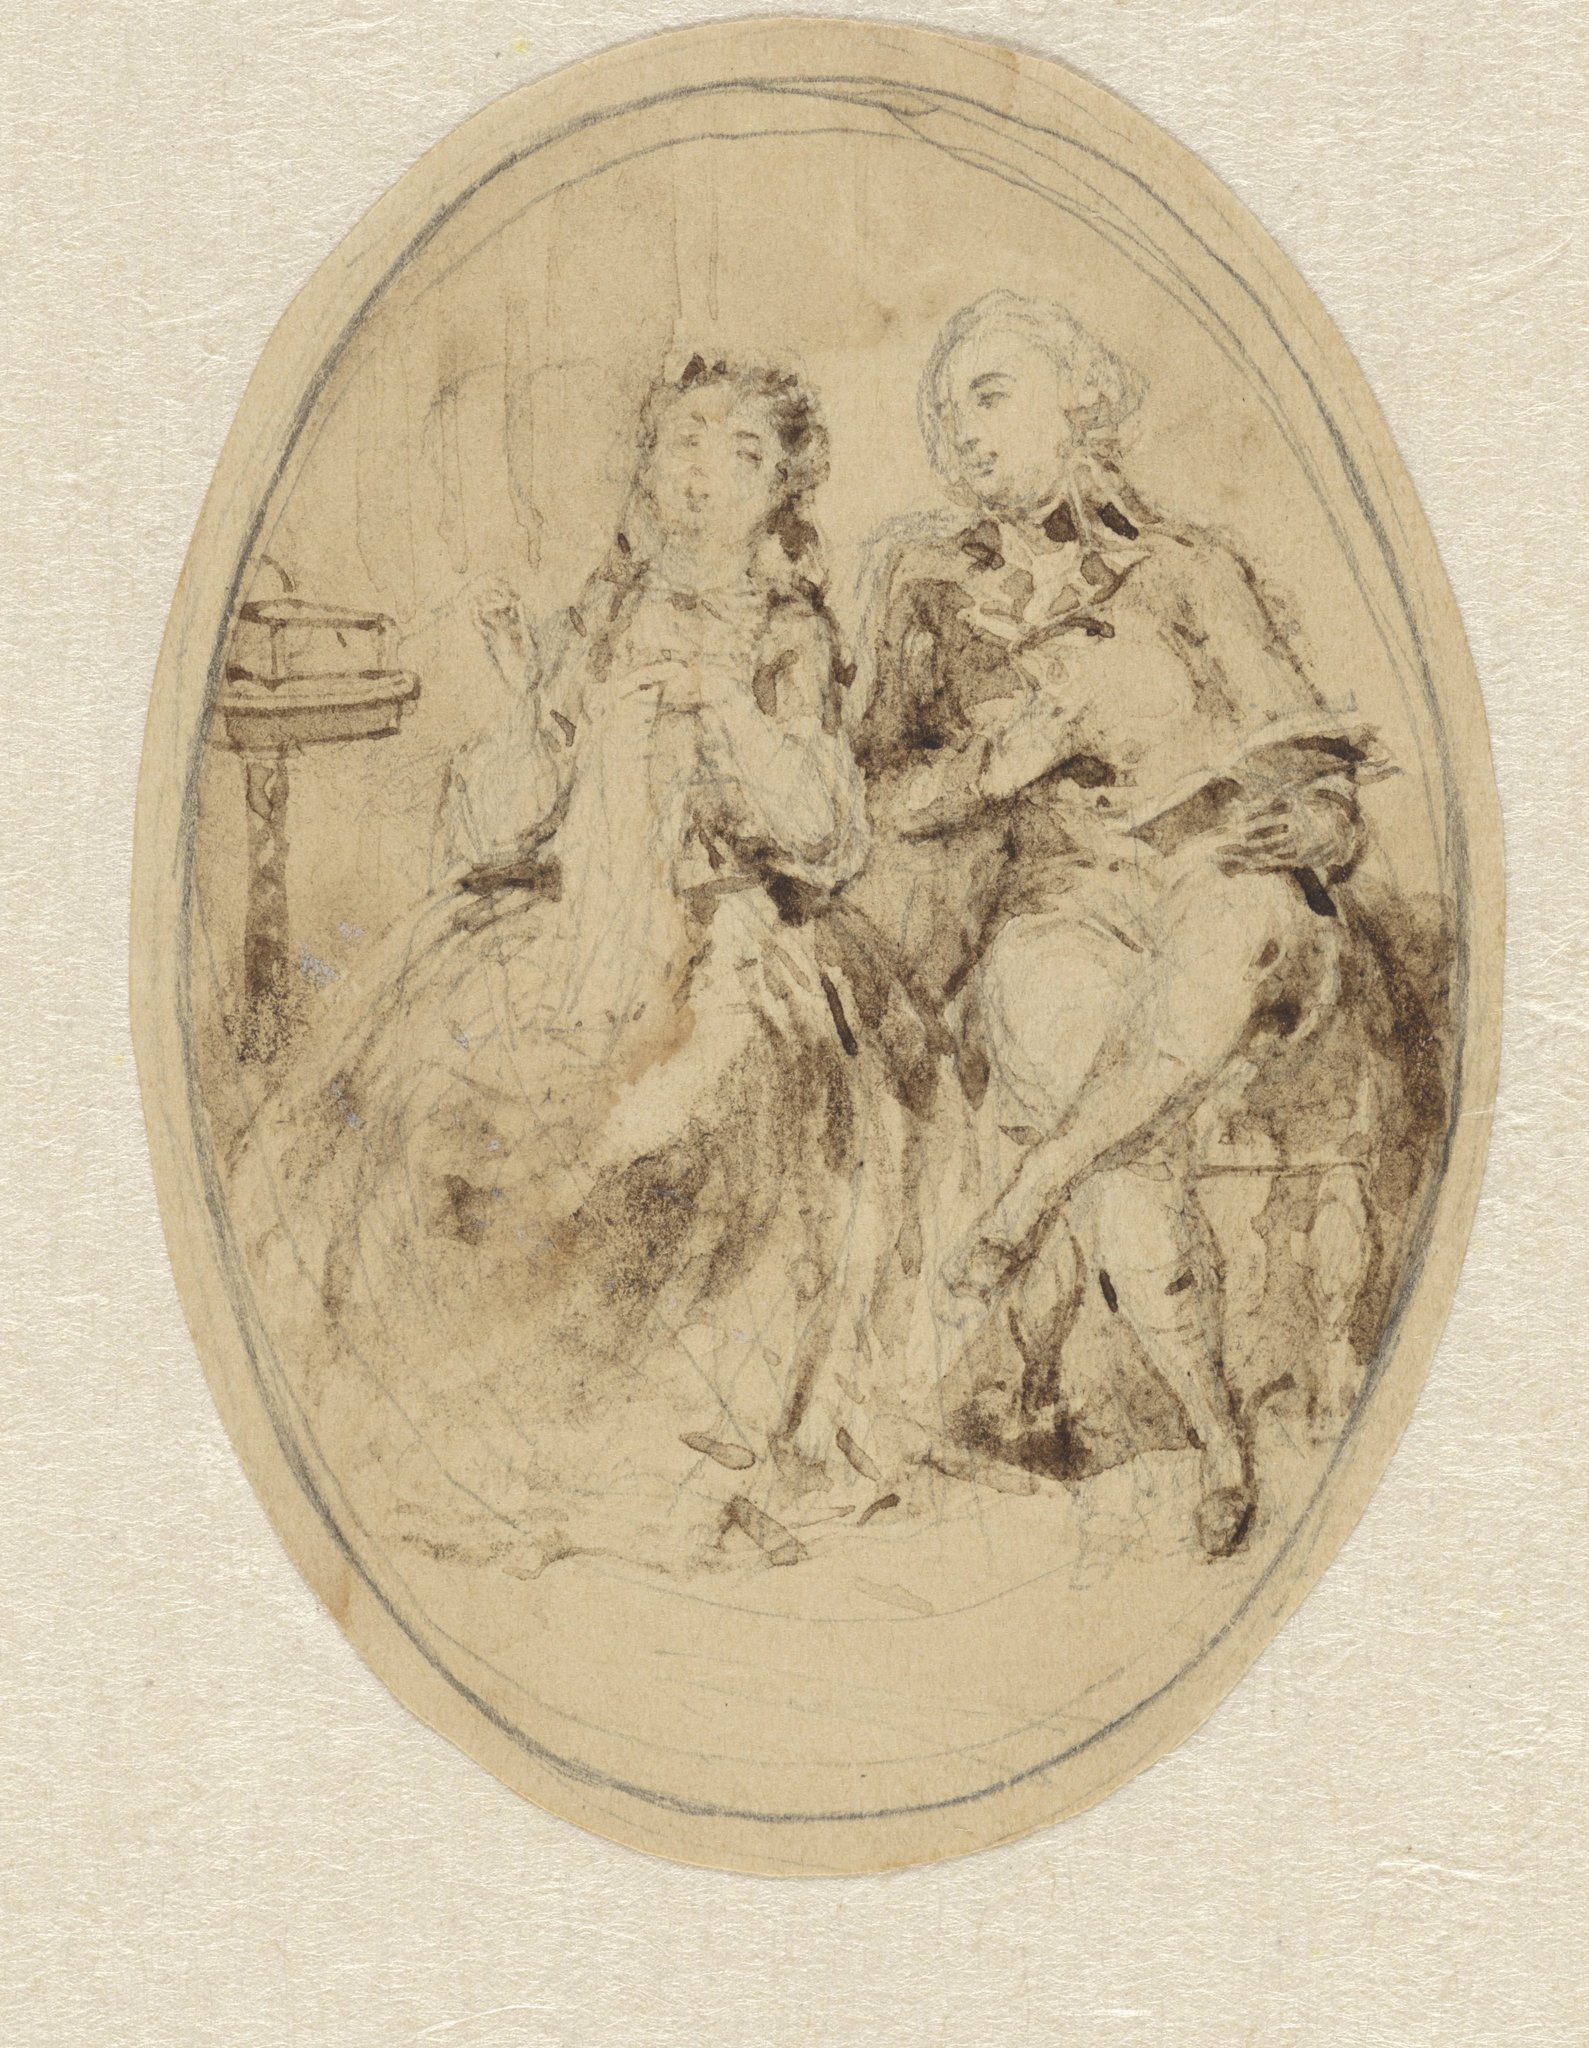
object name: design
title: Hofmakerij tussen elegant paar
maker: herman frederik carel ten kate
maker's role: draughtsman, painter, print maker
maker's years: 1822-1891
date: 1832-1891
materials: paper, pencil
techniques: brush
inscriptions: inscription: ‘A’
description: Boekillustratie voor roman uitgegeven door A.C. Kruseman te Haarlem, no.A (?)